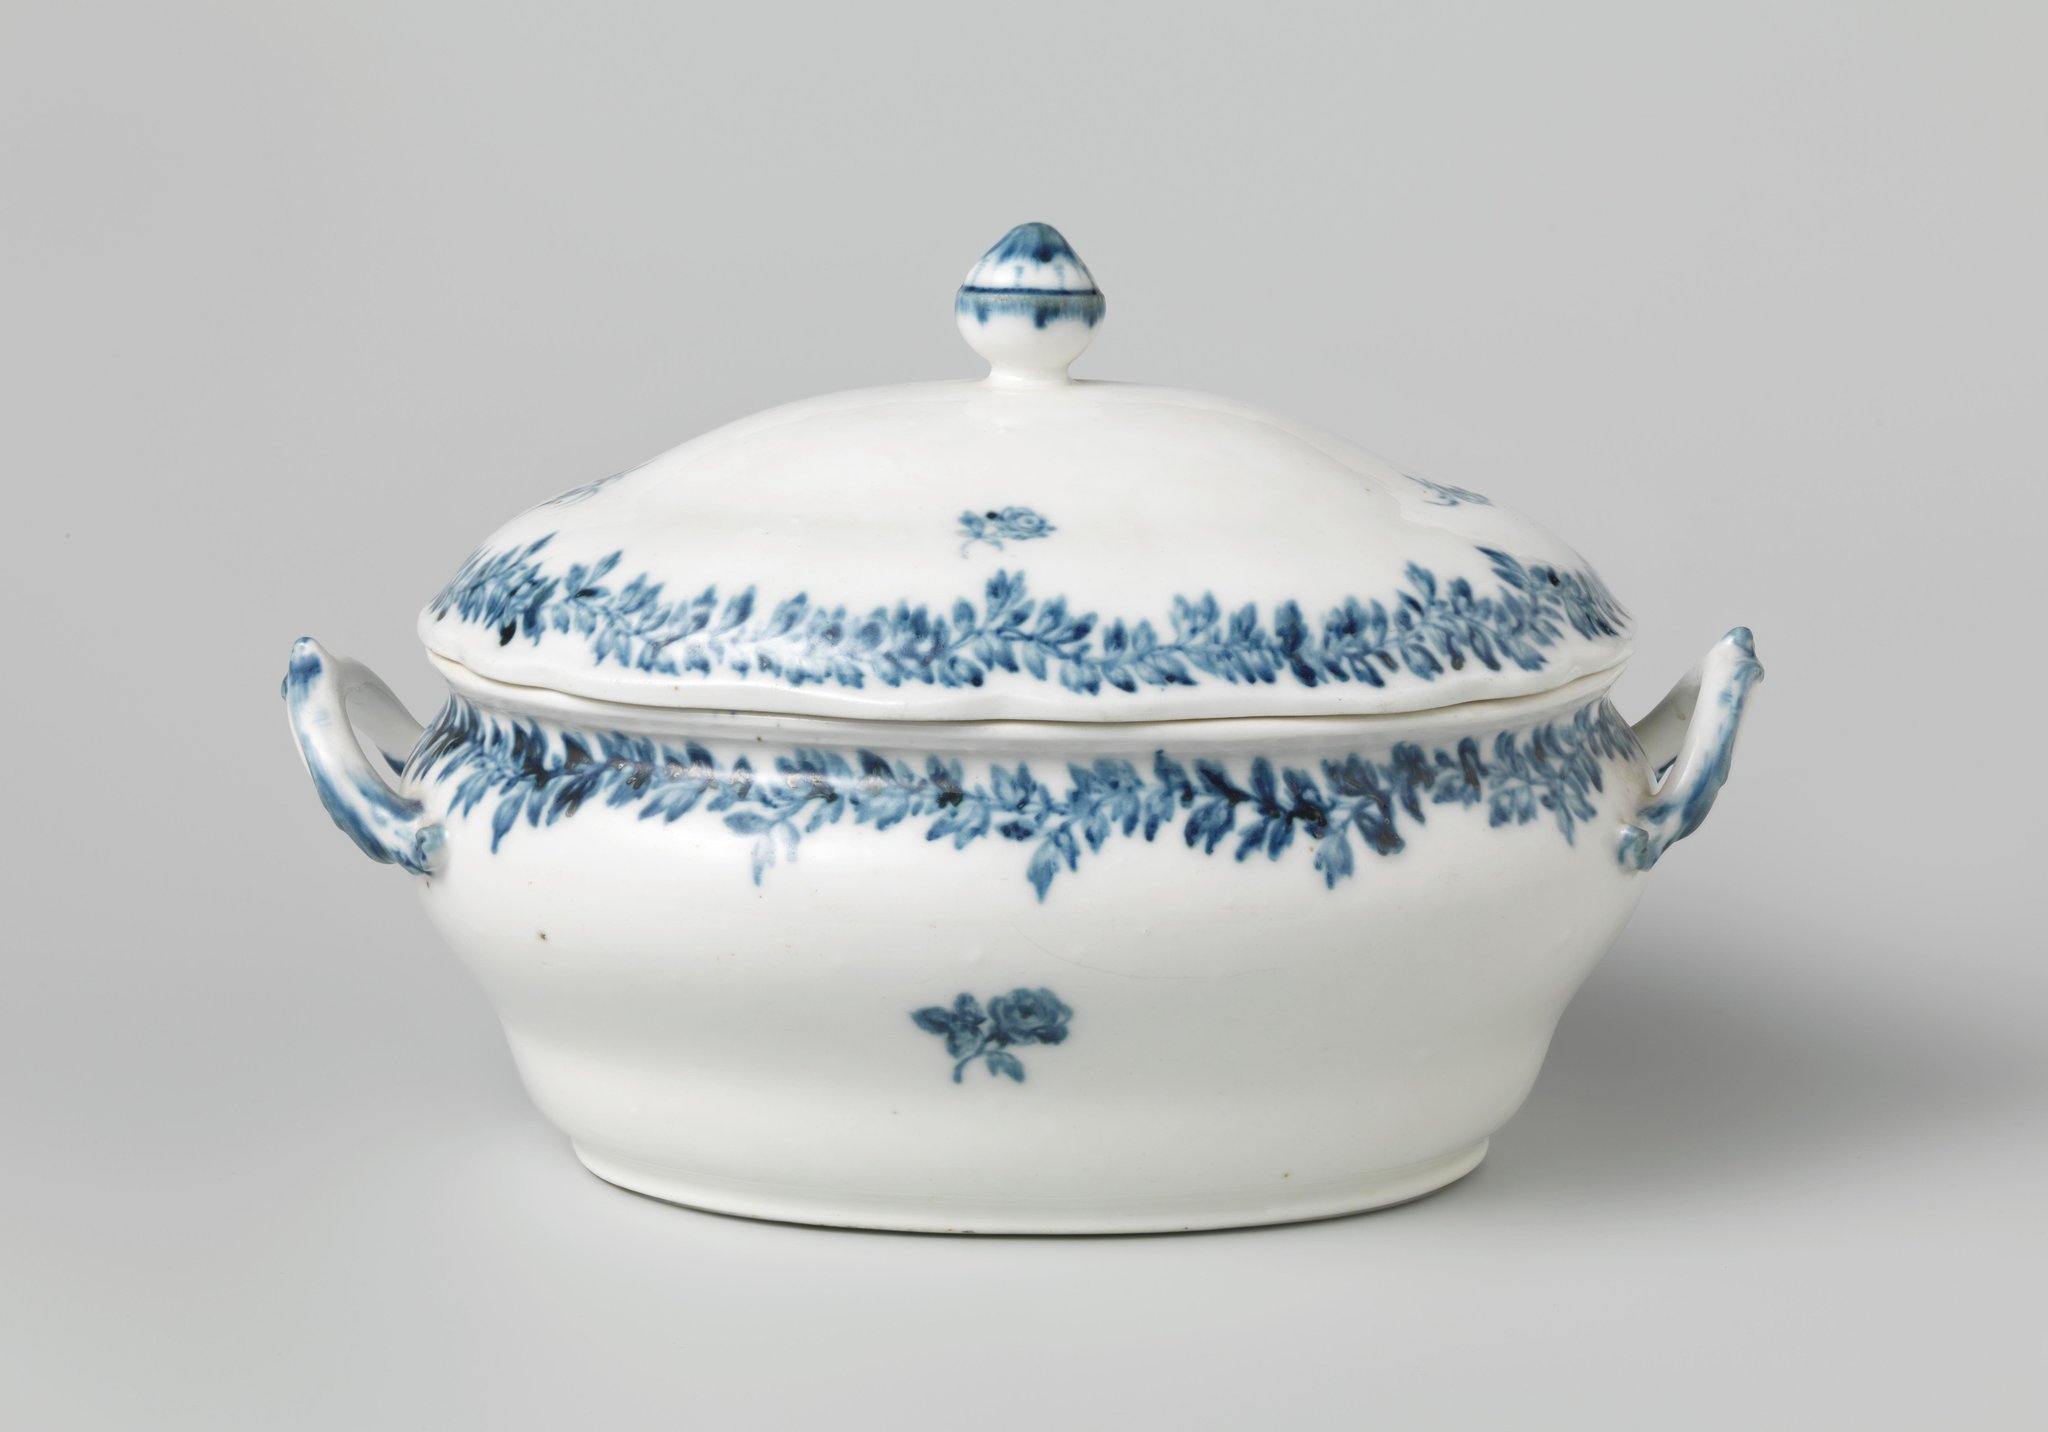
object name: tureen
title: Terrine met blad- en bloemslingers.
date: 1774-1784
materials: porcelain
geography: loosdrecht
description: Terrine met deksel van porselein. Beschilderd met blauwe blad- en bloemslingers.